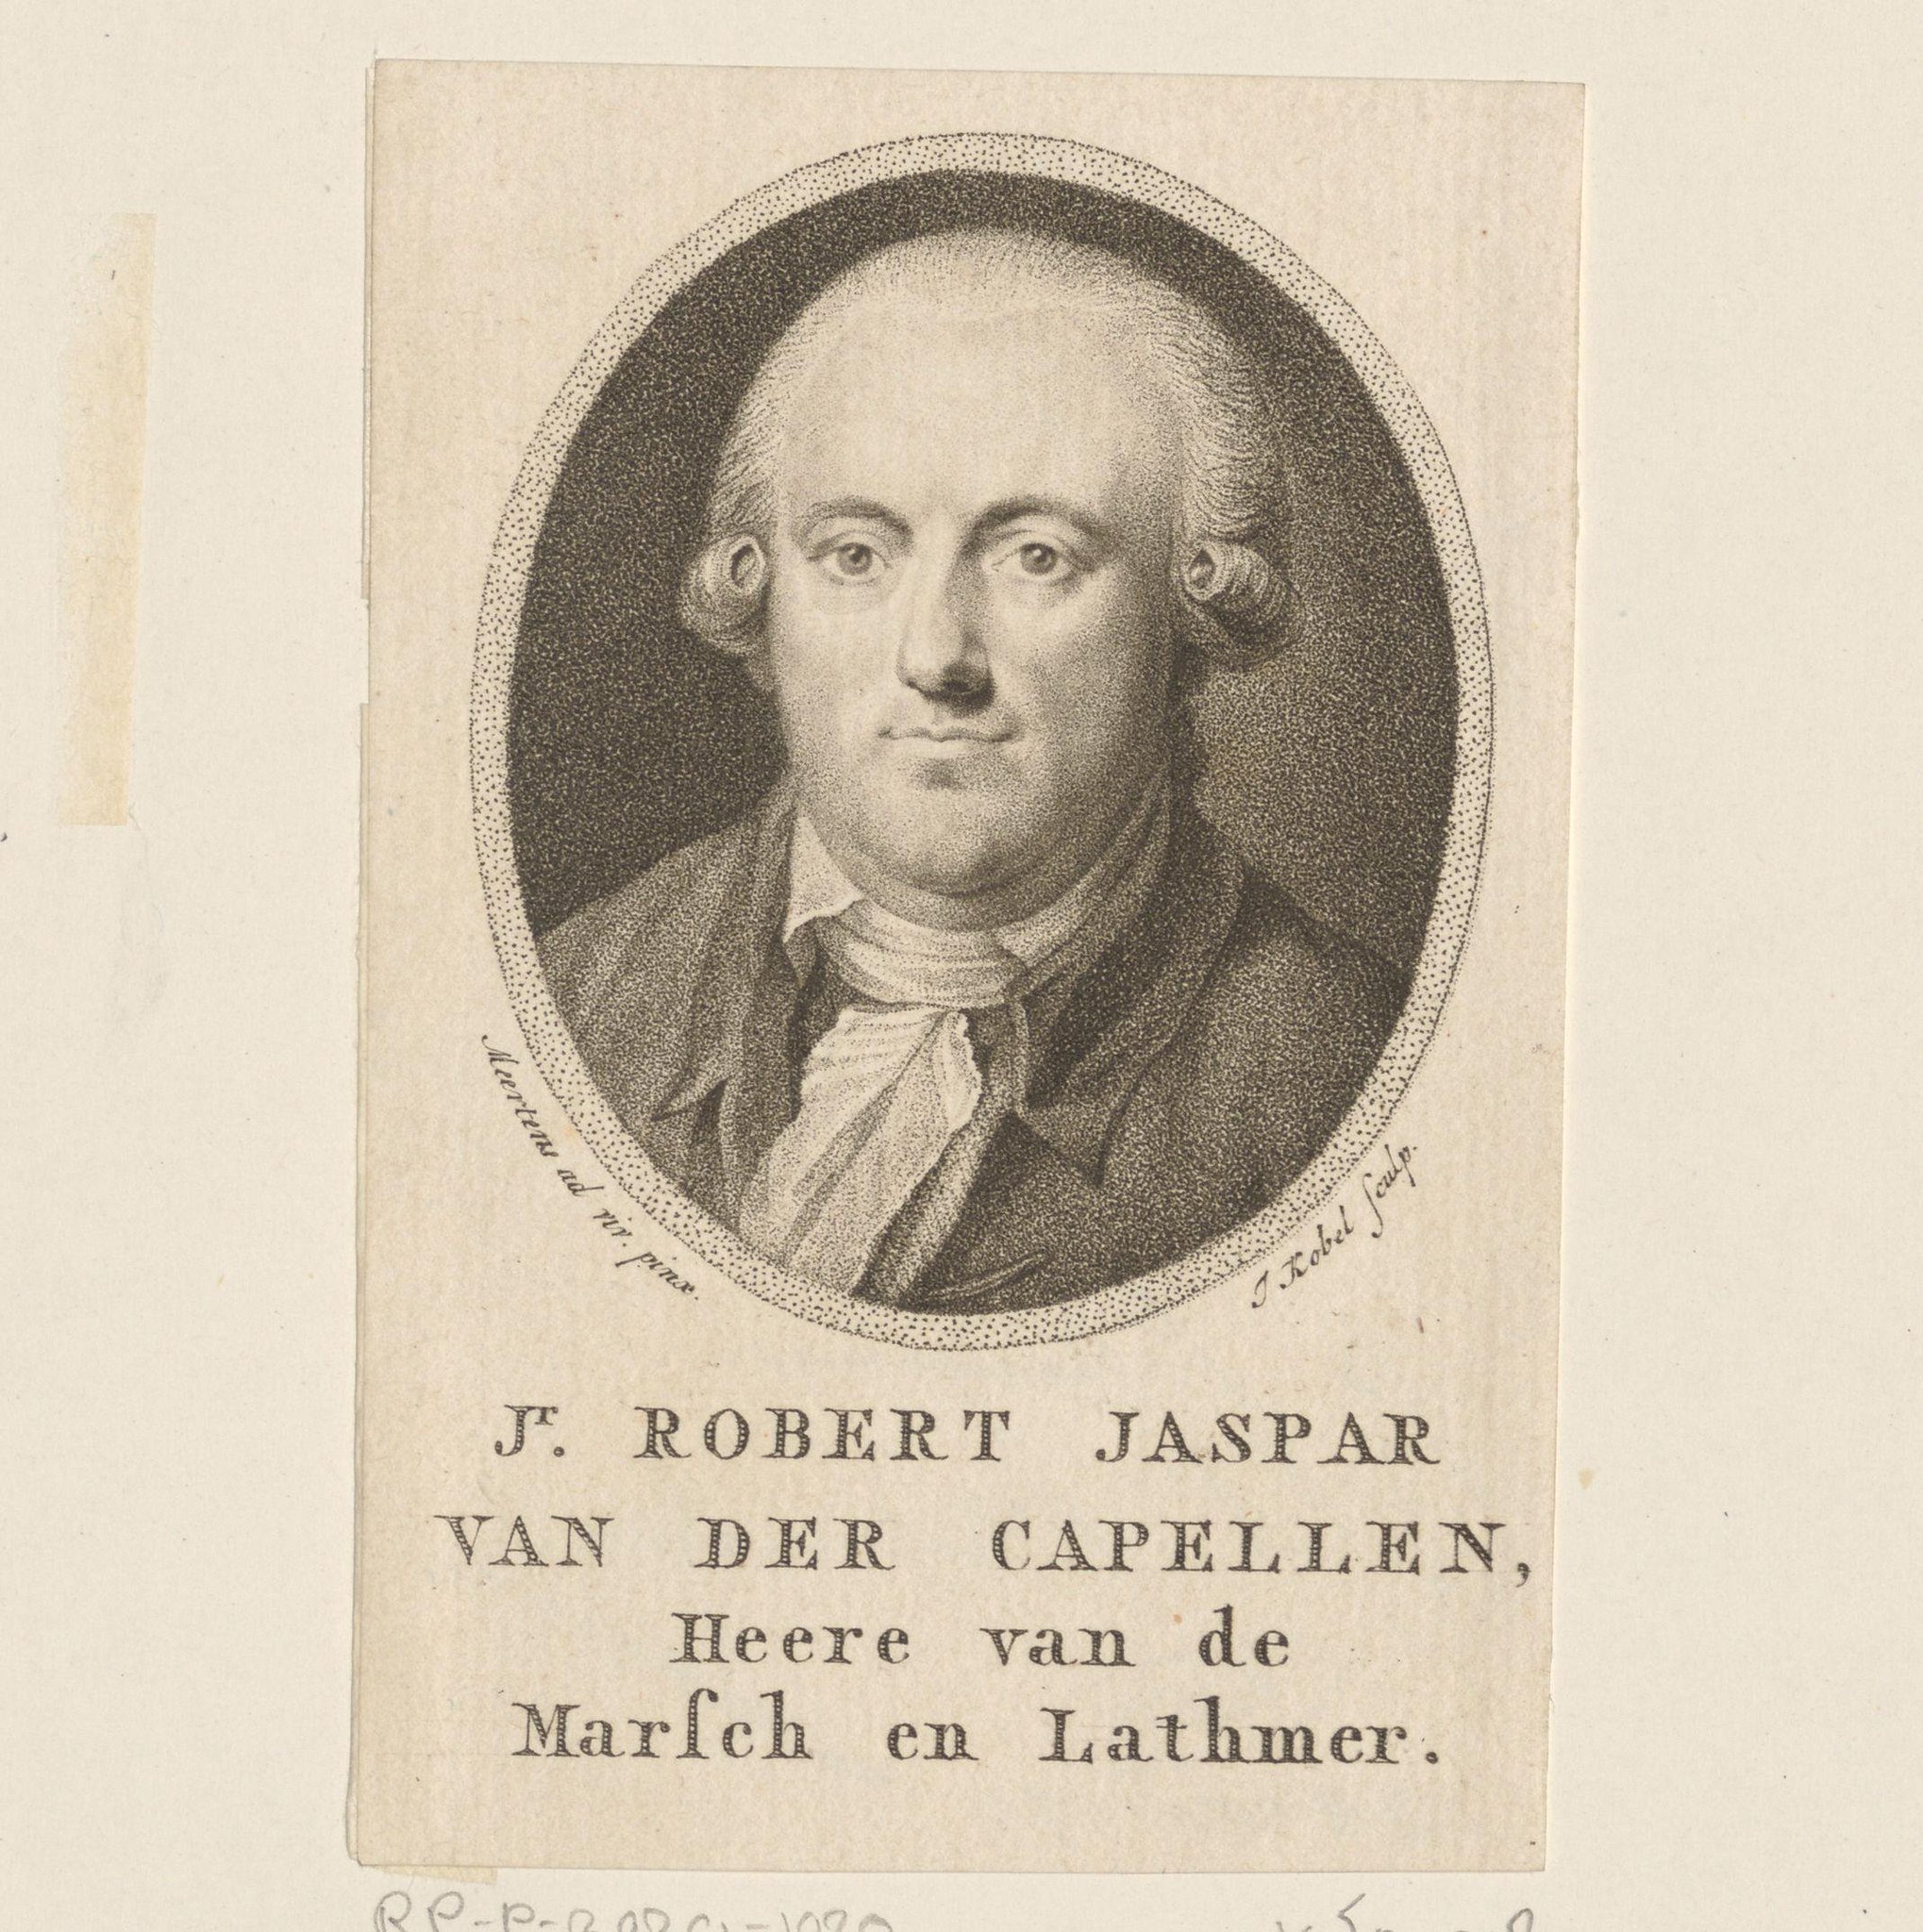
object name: print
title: Portret van Robert Jasper van der Capellen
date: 1766-1833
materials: paper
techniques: etching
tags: deventer, historical persons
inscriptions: collector's mark: Lugt 2228